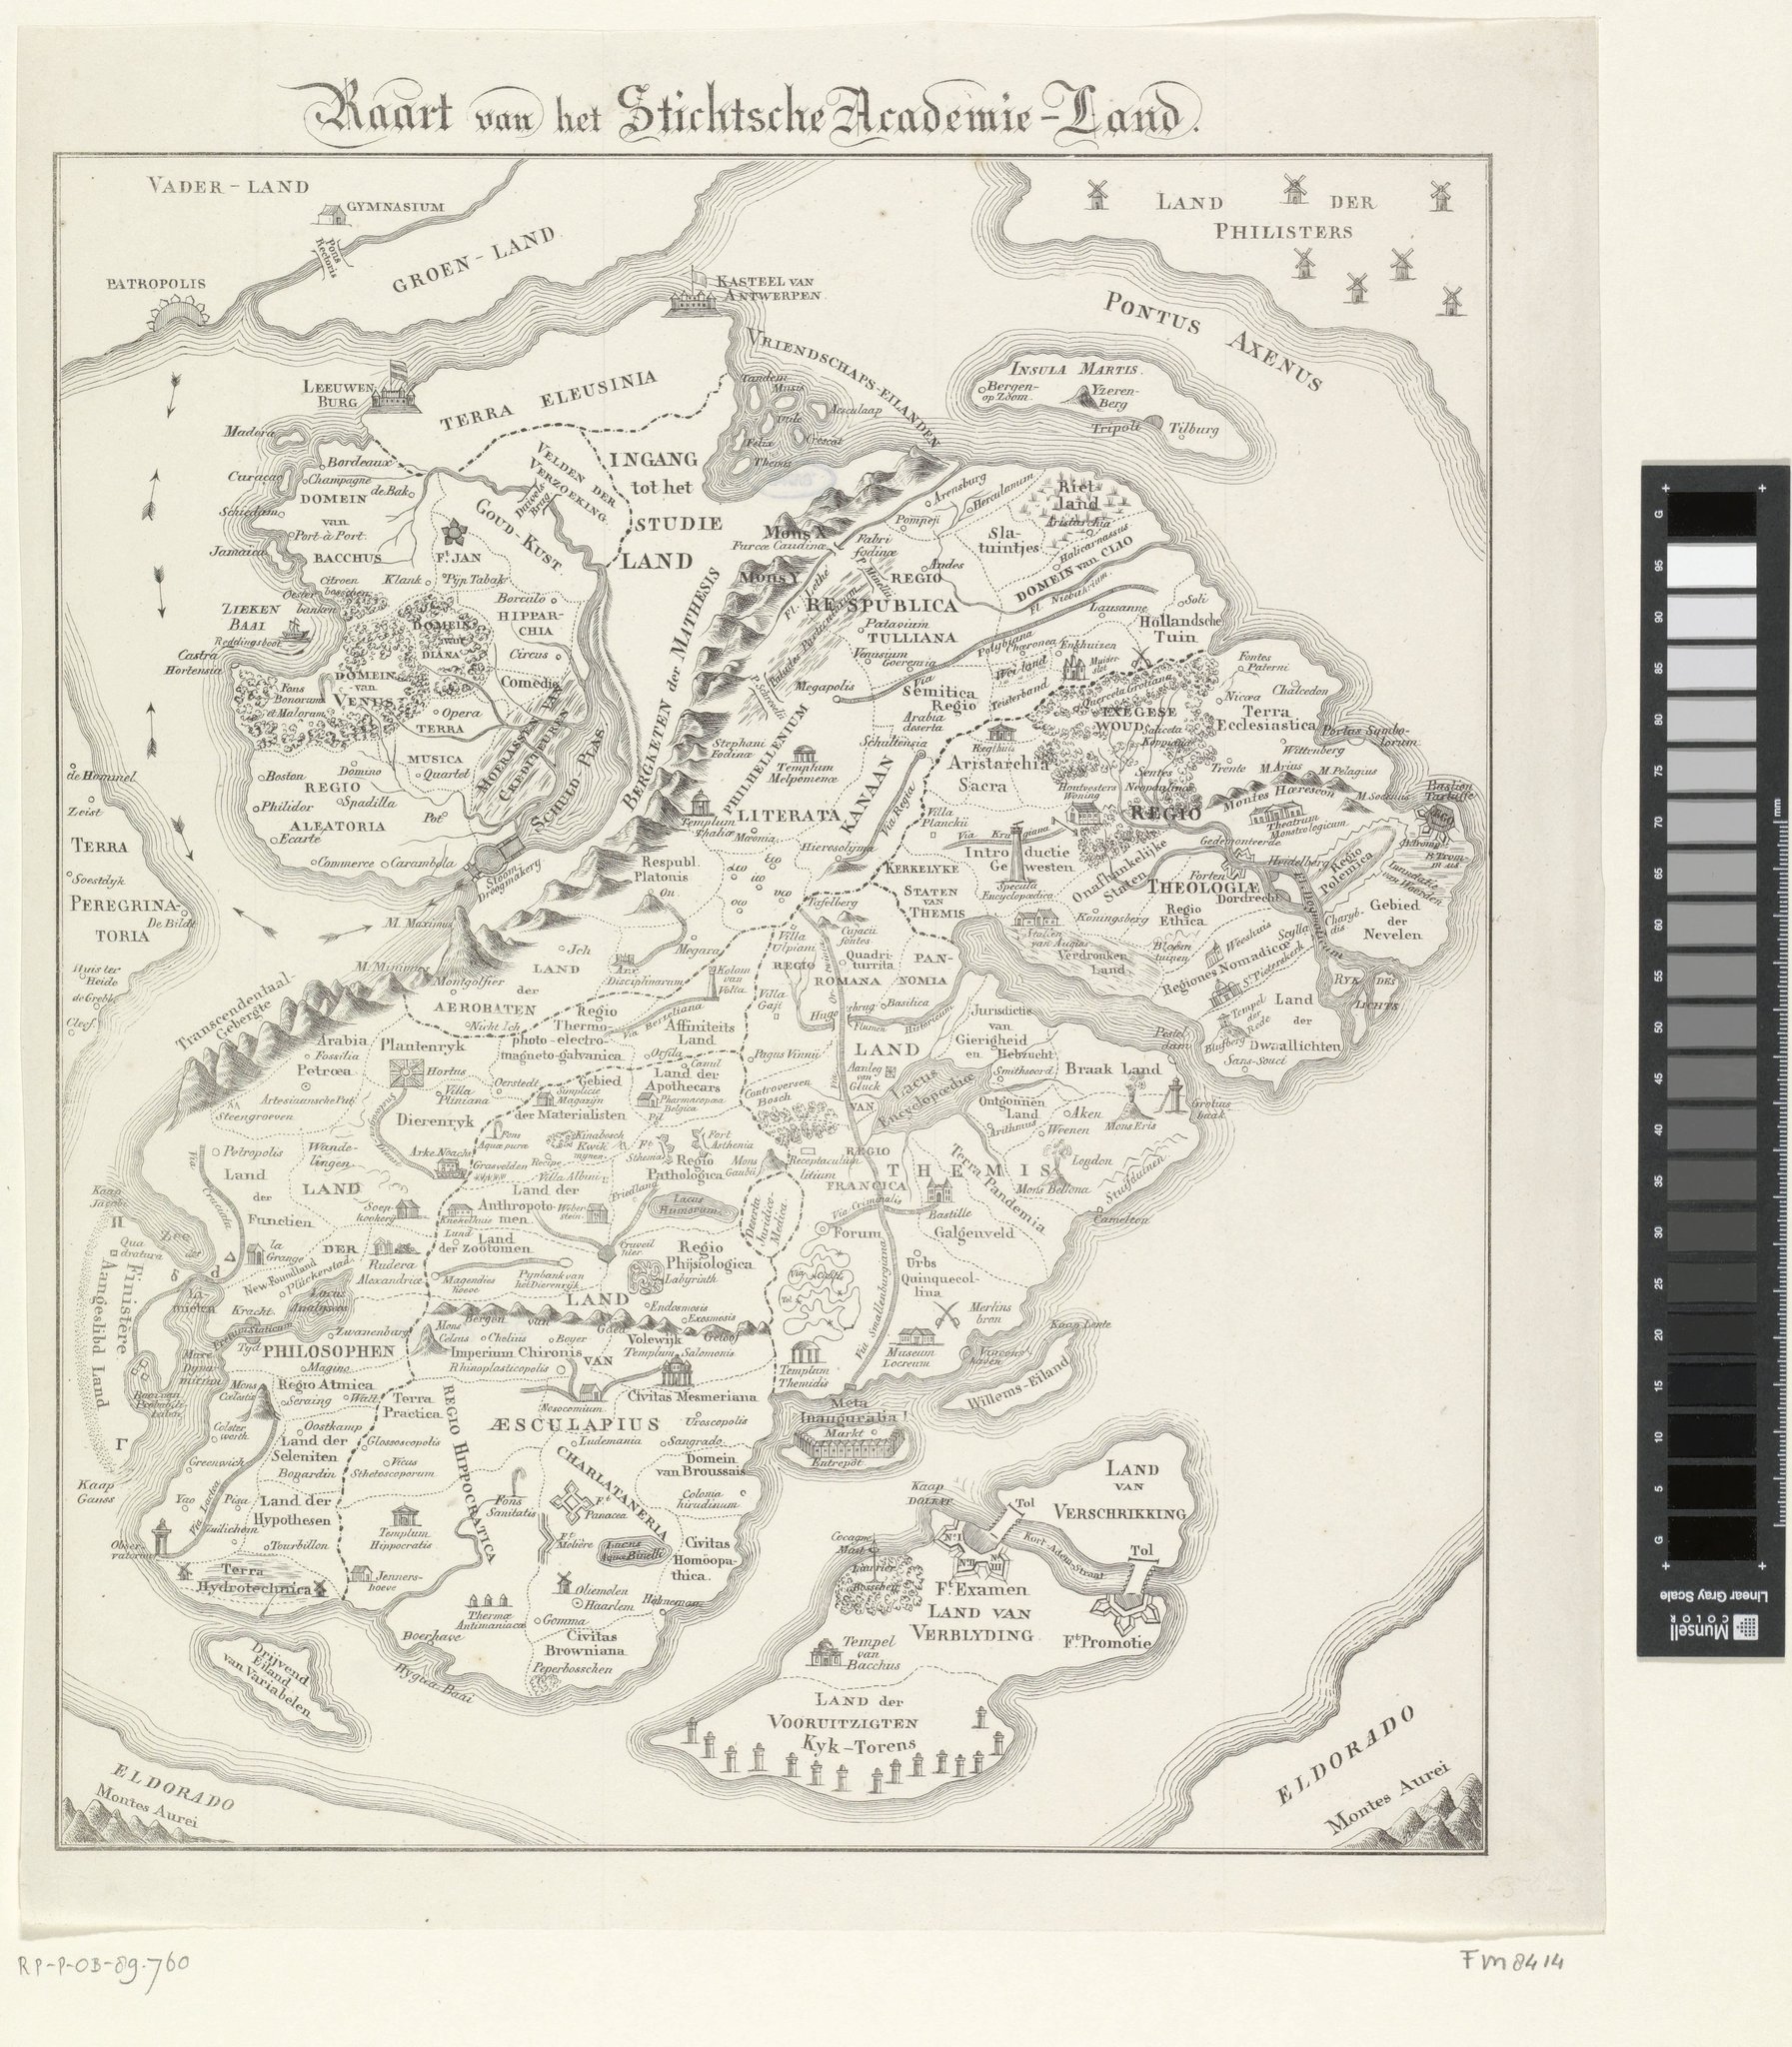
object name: print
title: Spotprent uit Utrechtse studentenalmanak, 1834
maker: Anonymous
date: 1834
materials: paper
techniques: lithograph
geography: netherlands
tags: maps of separate countries or regions, fictitious countries, student life, utrecht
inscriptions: collector's mark: Lugt 2228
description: Spotprent uit de studentenalmanak van de Universiteit van Utrecht van het jaar 1834. Kaart van een fictief eiland vol met plaatsen en kenmerken met namen in het Latijn (en Nederlands) die verwijzen naar de studie op de universiteit.